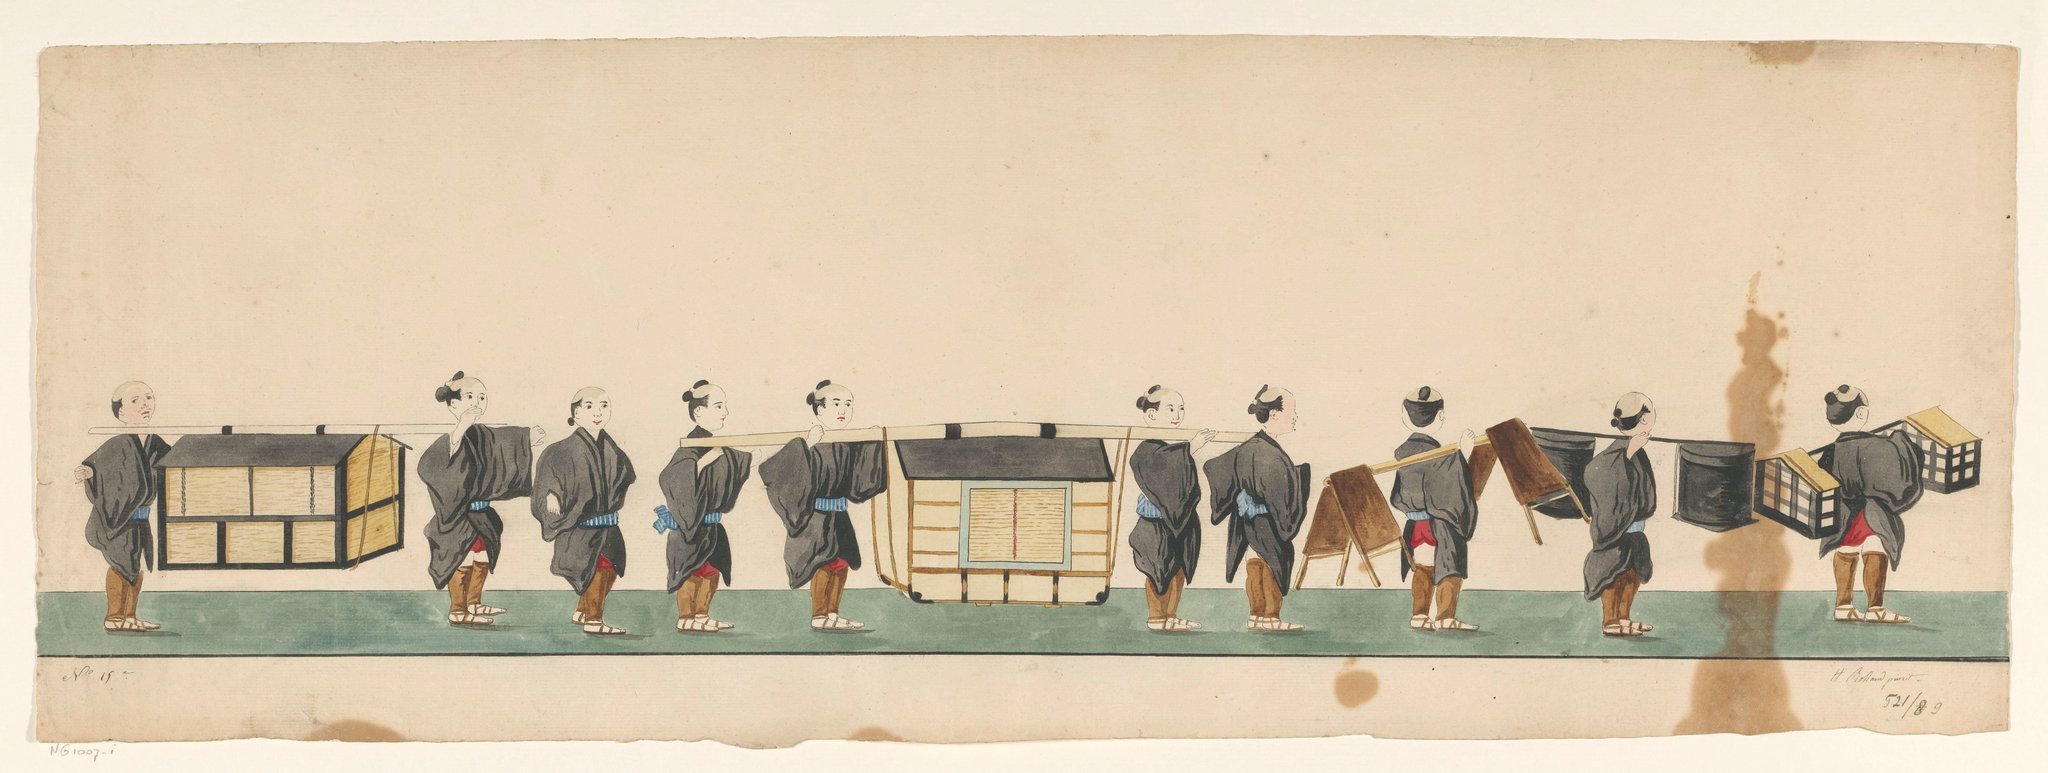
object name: drawing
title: Stoet van tien Japanse dragers met verschillende pakketten aan draagstokken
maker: henry rolland de verberie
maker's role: painter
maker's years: 1750-1800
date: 1775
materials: ink, paper, watercolor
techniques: brush, pen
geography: japan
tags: carrying something with carrying-pole, (carrying a person in a) sedan-chair, japan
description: Stoet van tien Japanse dragers met verschillende pakketten aan draagstokken, naar rechts. Onderdeel van een reeks van tien pentekeningen met een stoet van paarden geleid door Japanse mannen, die naar rechts en op twee bladen naar links zich bewegen, en pakketten dragen met deels het embleem van de VOC Zeeland. Genummerd linksonder: No. 15., rechtsonder: 521/9.